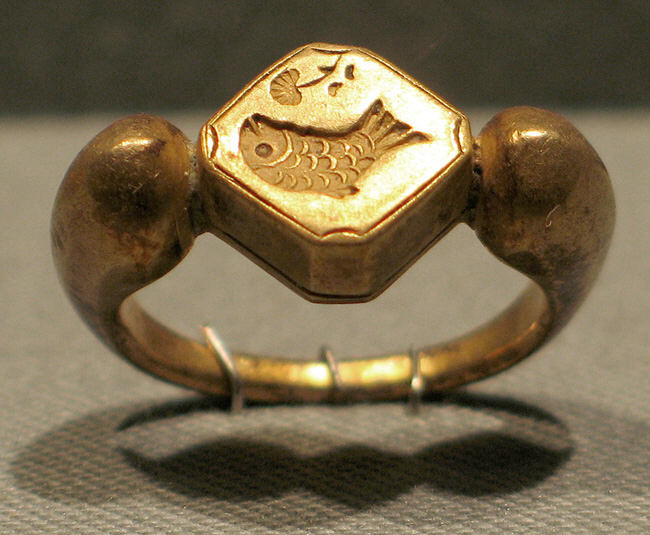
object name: ring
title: Stirrup-Shaped Ring with Fish Design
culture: indonesian, javanese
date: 701-933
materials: gold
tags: fish